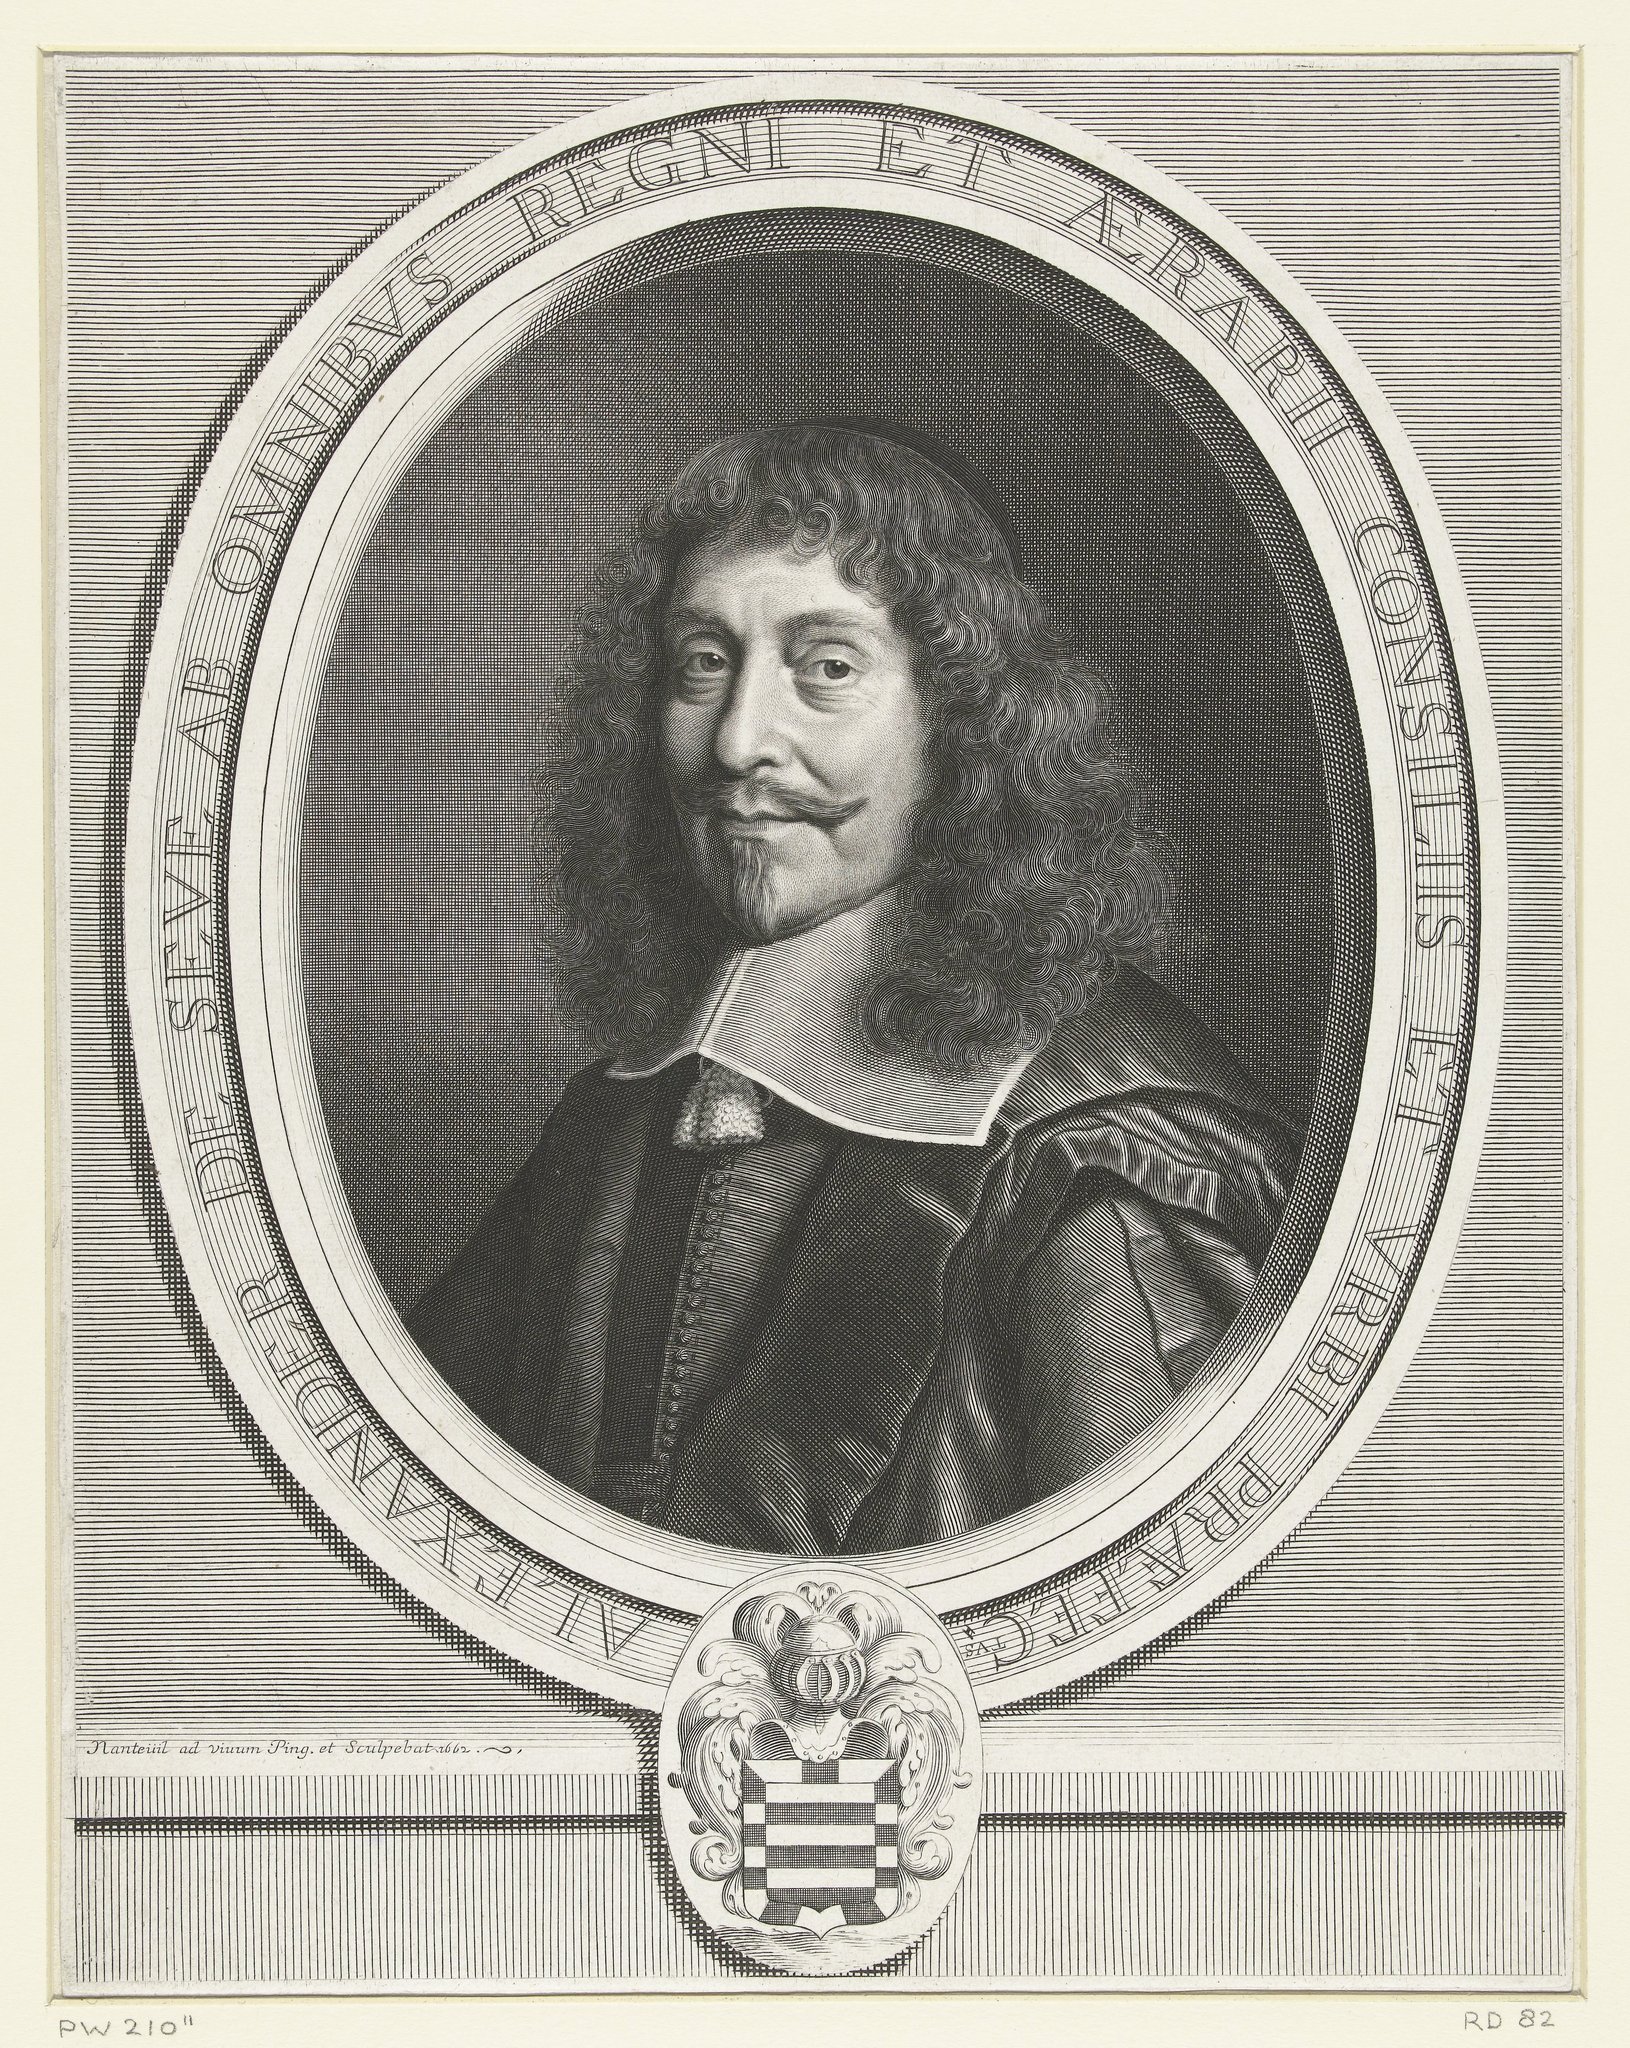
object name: print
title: Portret van Alexandre de Sève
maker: robert nanteuil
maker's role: print maker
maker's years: 1623-1678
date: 1662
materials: paper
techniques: engraving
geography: france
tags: staatsman, alexandre de sève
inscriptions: collector's mark: Lugt 2228, collector's mark: Lugt 2760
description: Portret van de staatsadviseur Alexandre de Sève, in een ovale omlijsting met tekst. Onderaan een wapenschild.